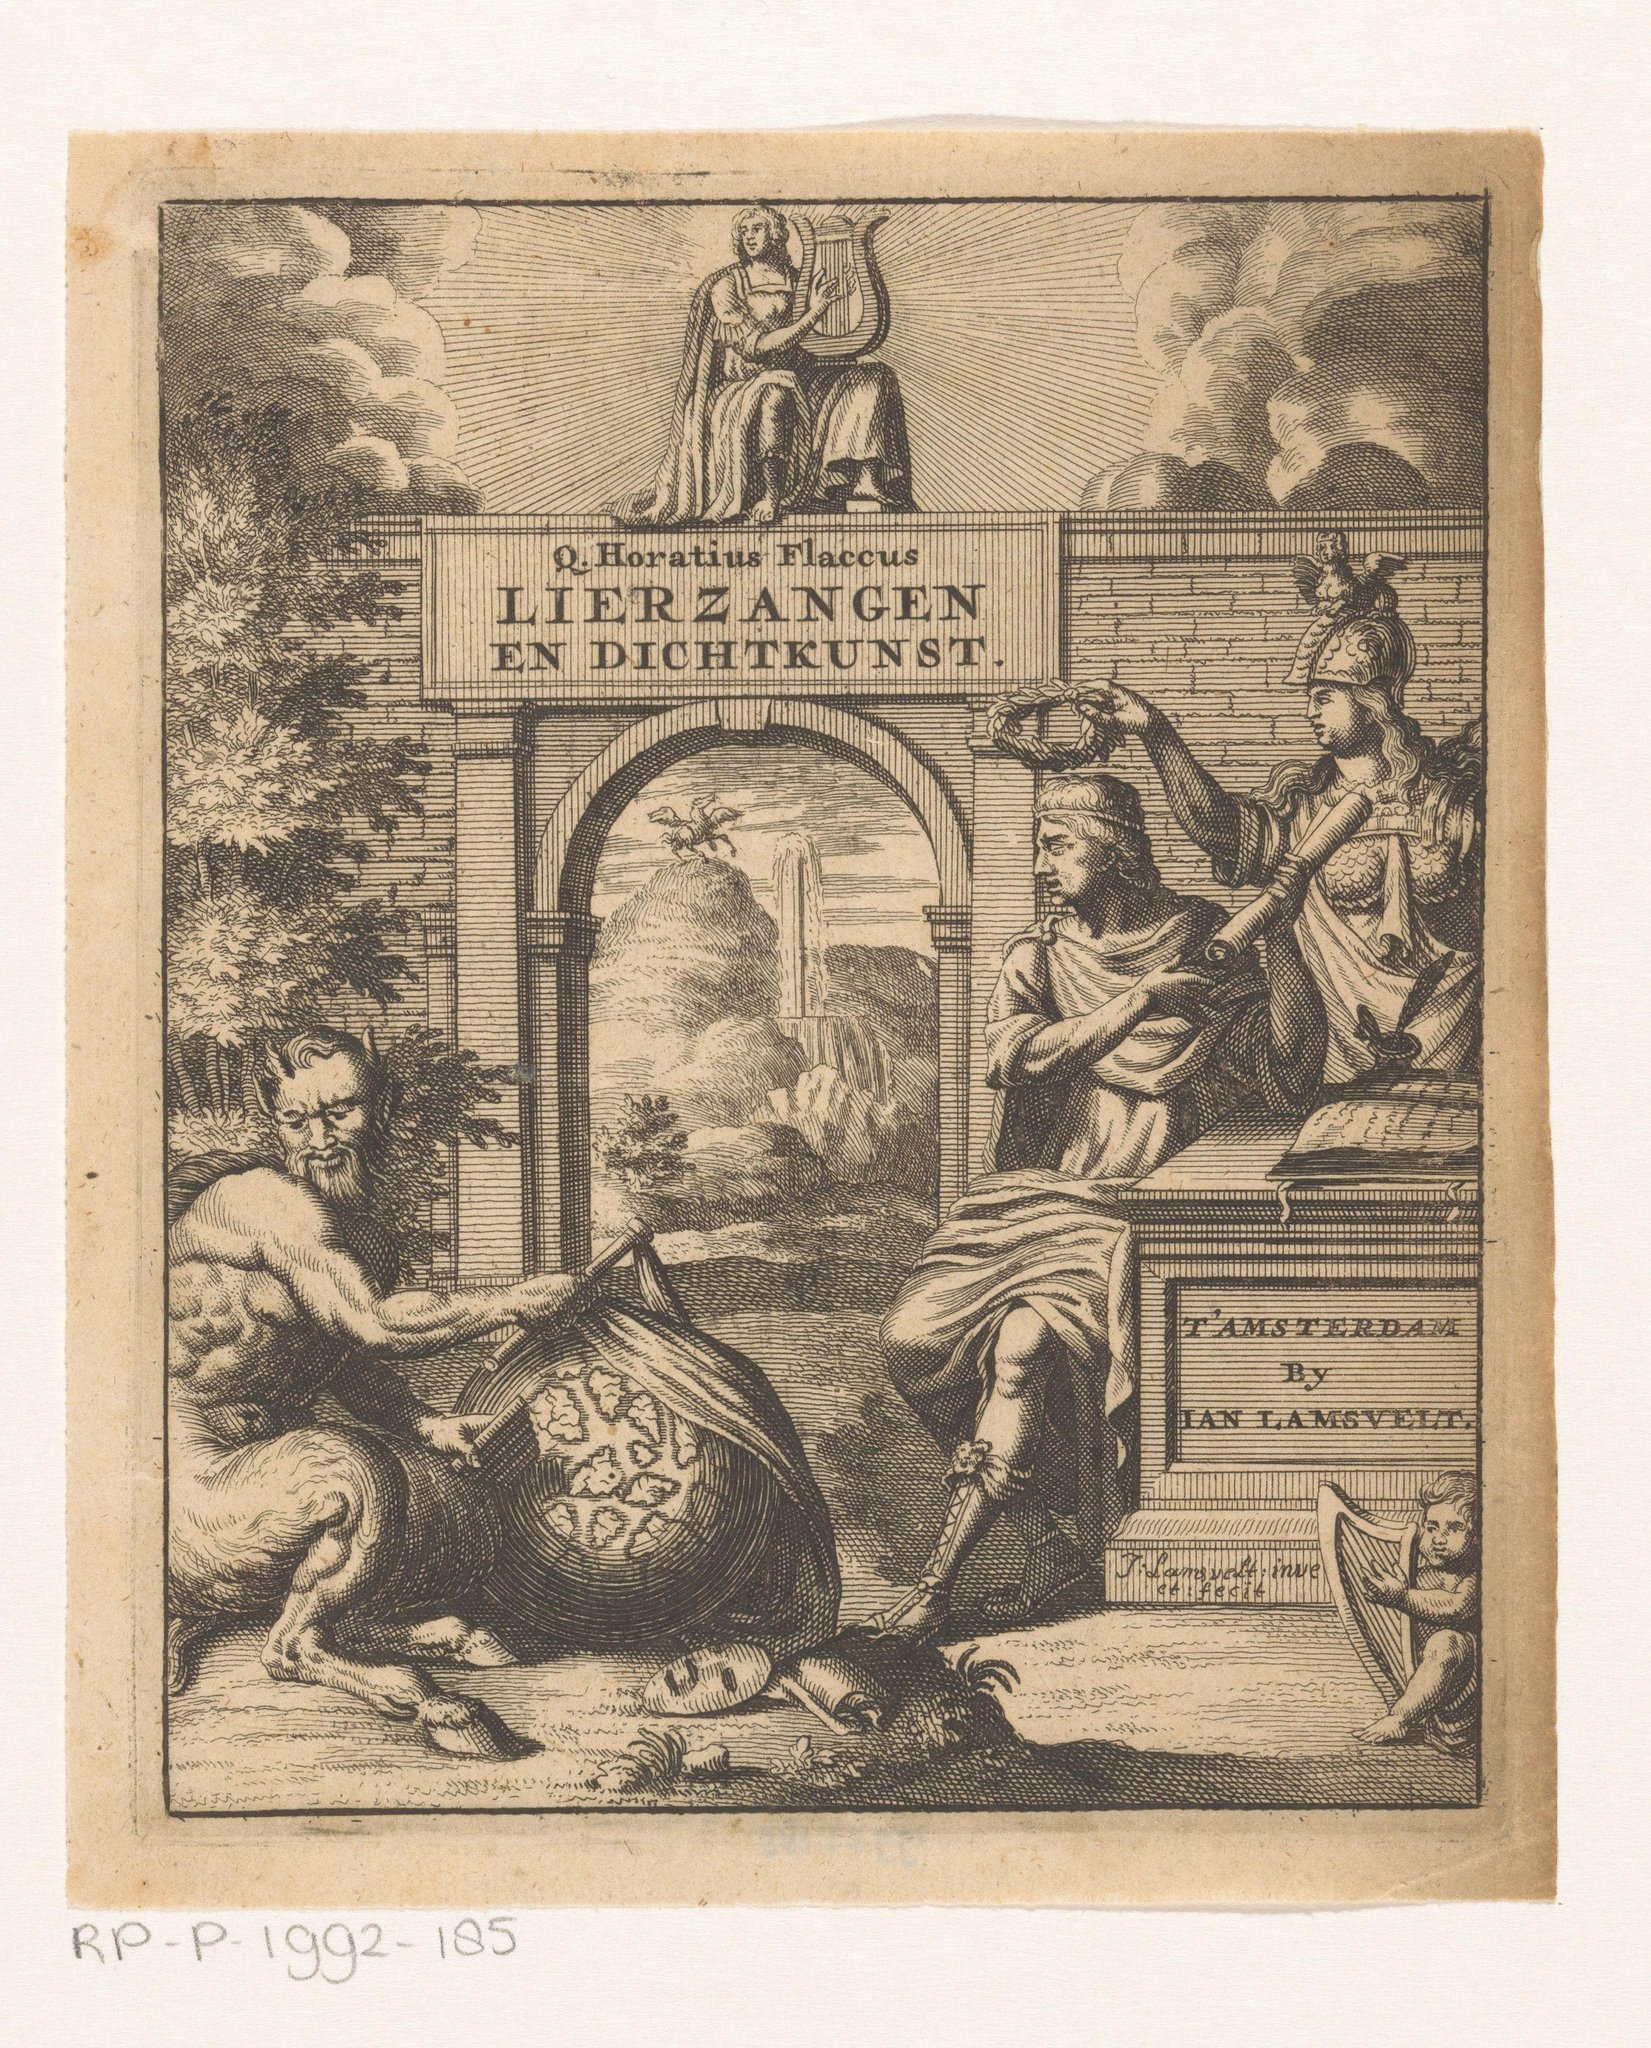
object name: print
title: Titelpagina voor: Horatius en Joost van den Vondel, Lierzangen en dichtkunst, 1703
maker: jan lamsvelt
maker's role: print maker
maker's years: 1674-1743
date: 1703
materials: paper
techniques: engraving, etching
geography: amsterdam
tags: (story of) minerva (pallas, athena), satyr(s) (in general), apollo playing the lyre, apollo citharoedus, crowning with laurel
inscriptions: collector's mark: Lugt 2228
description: Apollo spelend op zijn lier zit bovenop een muur met rondboog. Op de voorgrond wordt rechts een man gelauwerd door Minerva en zit links een sater met globe en panfluit. In de achtergrond Pegasus op de berg Parnassus.